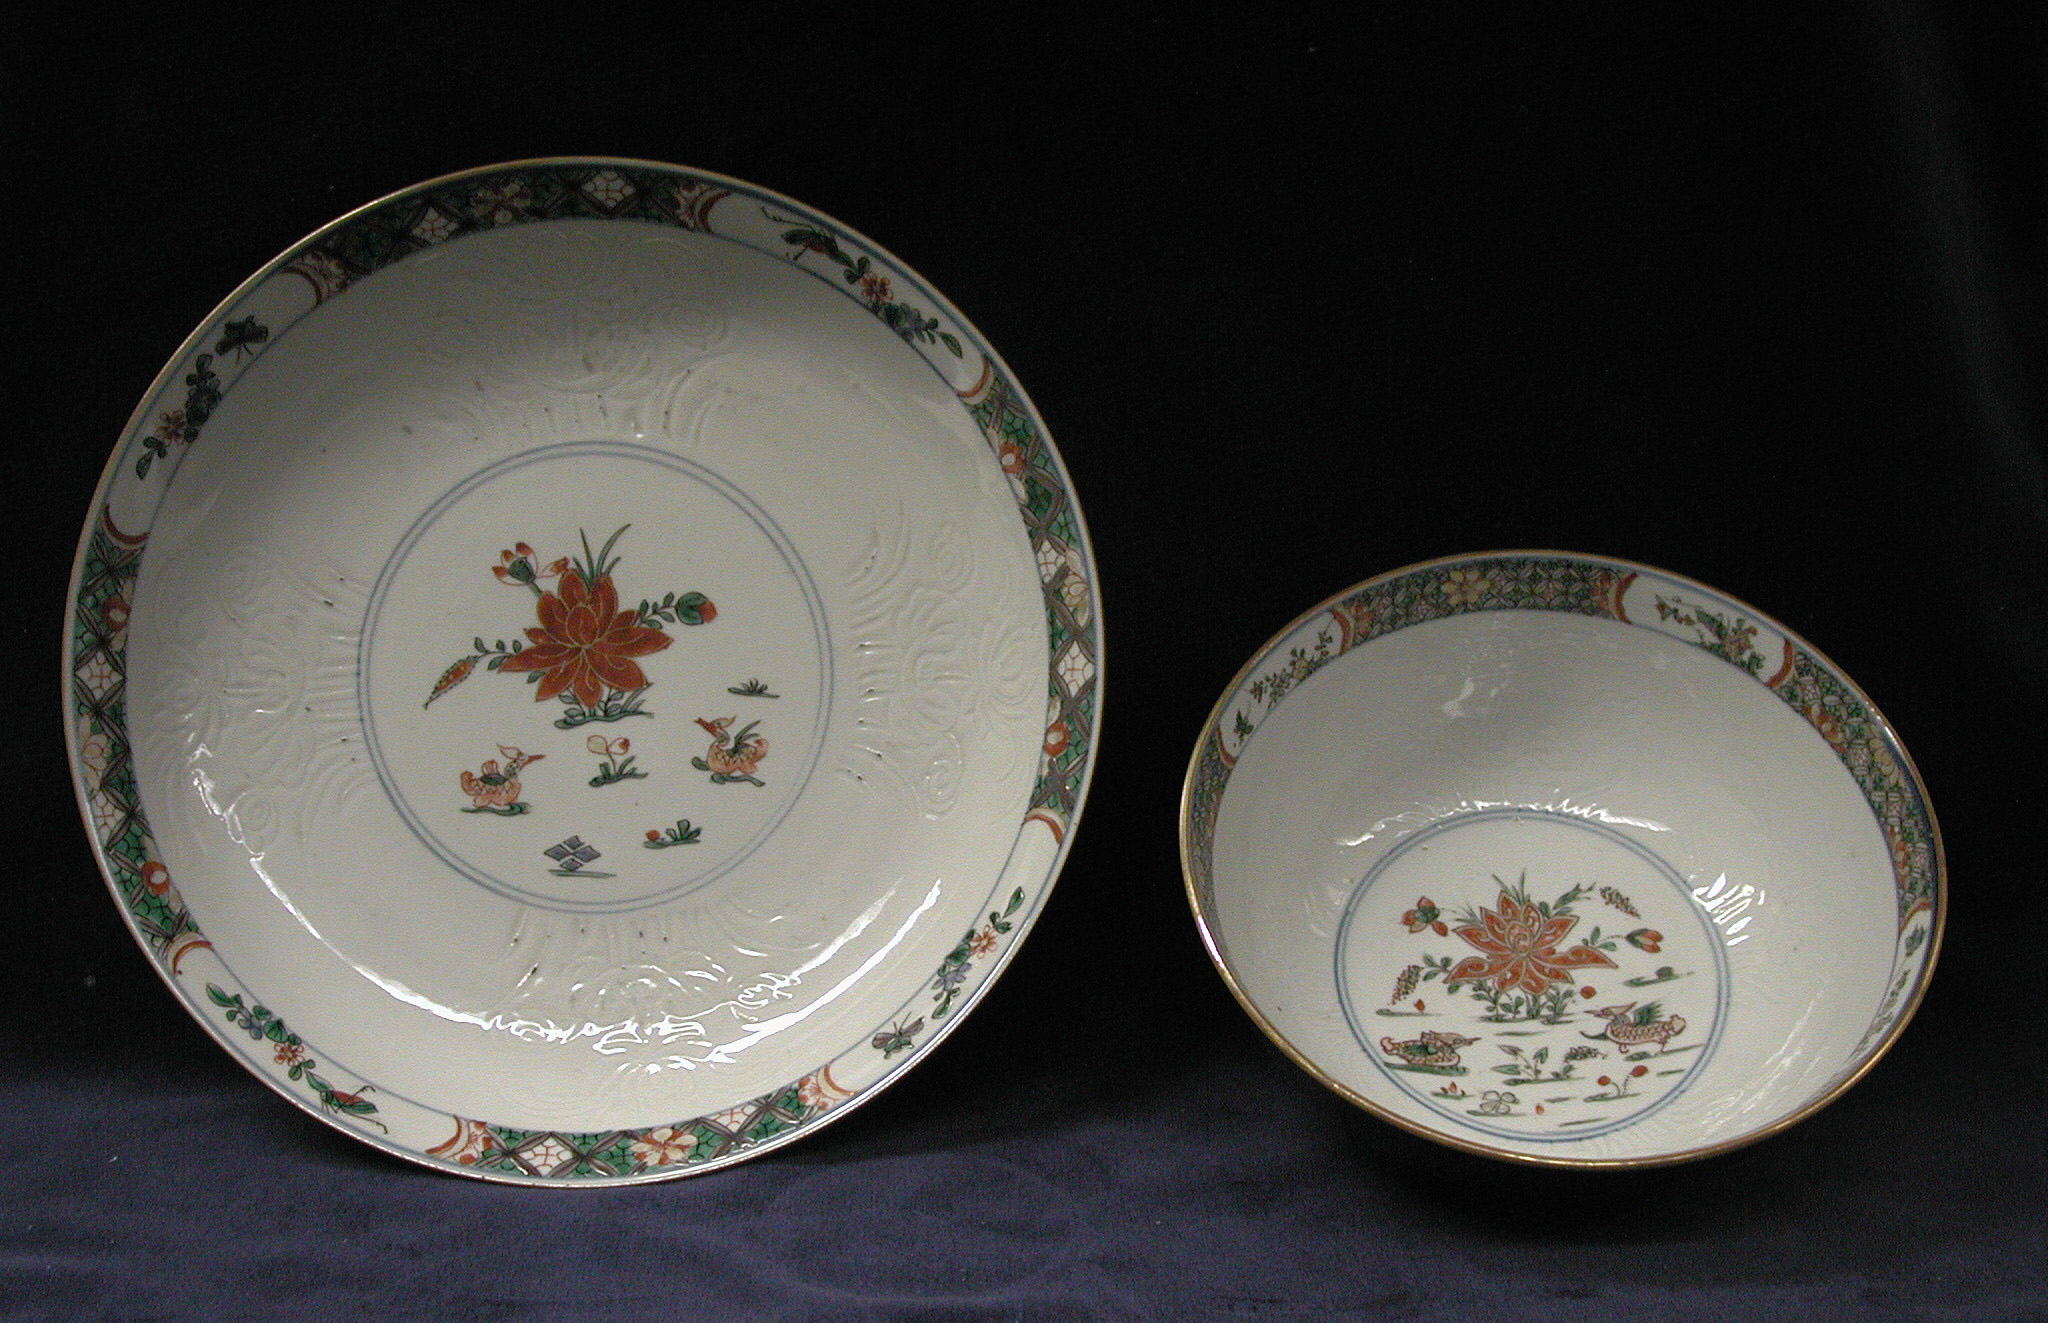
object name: bowl and dish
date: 1700-1720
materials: hard paste porcelain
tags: birds,flowers